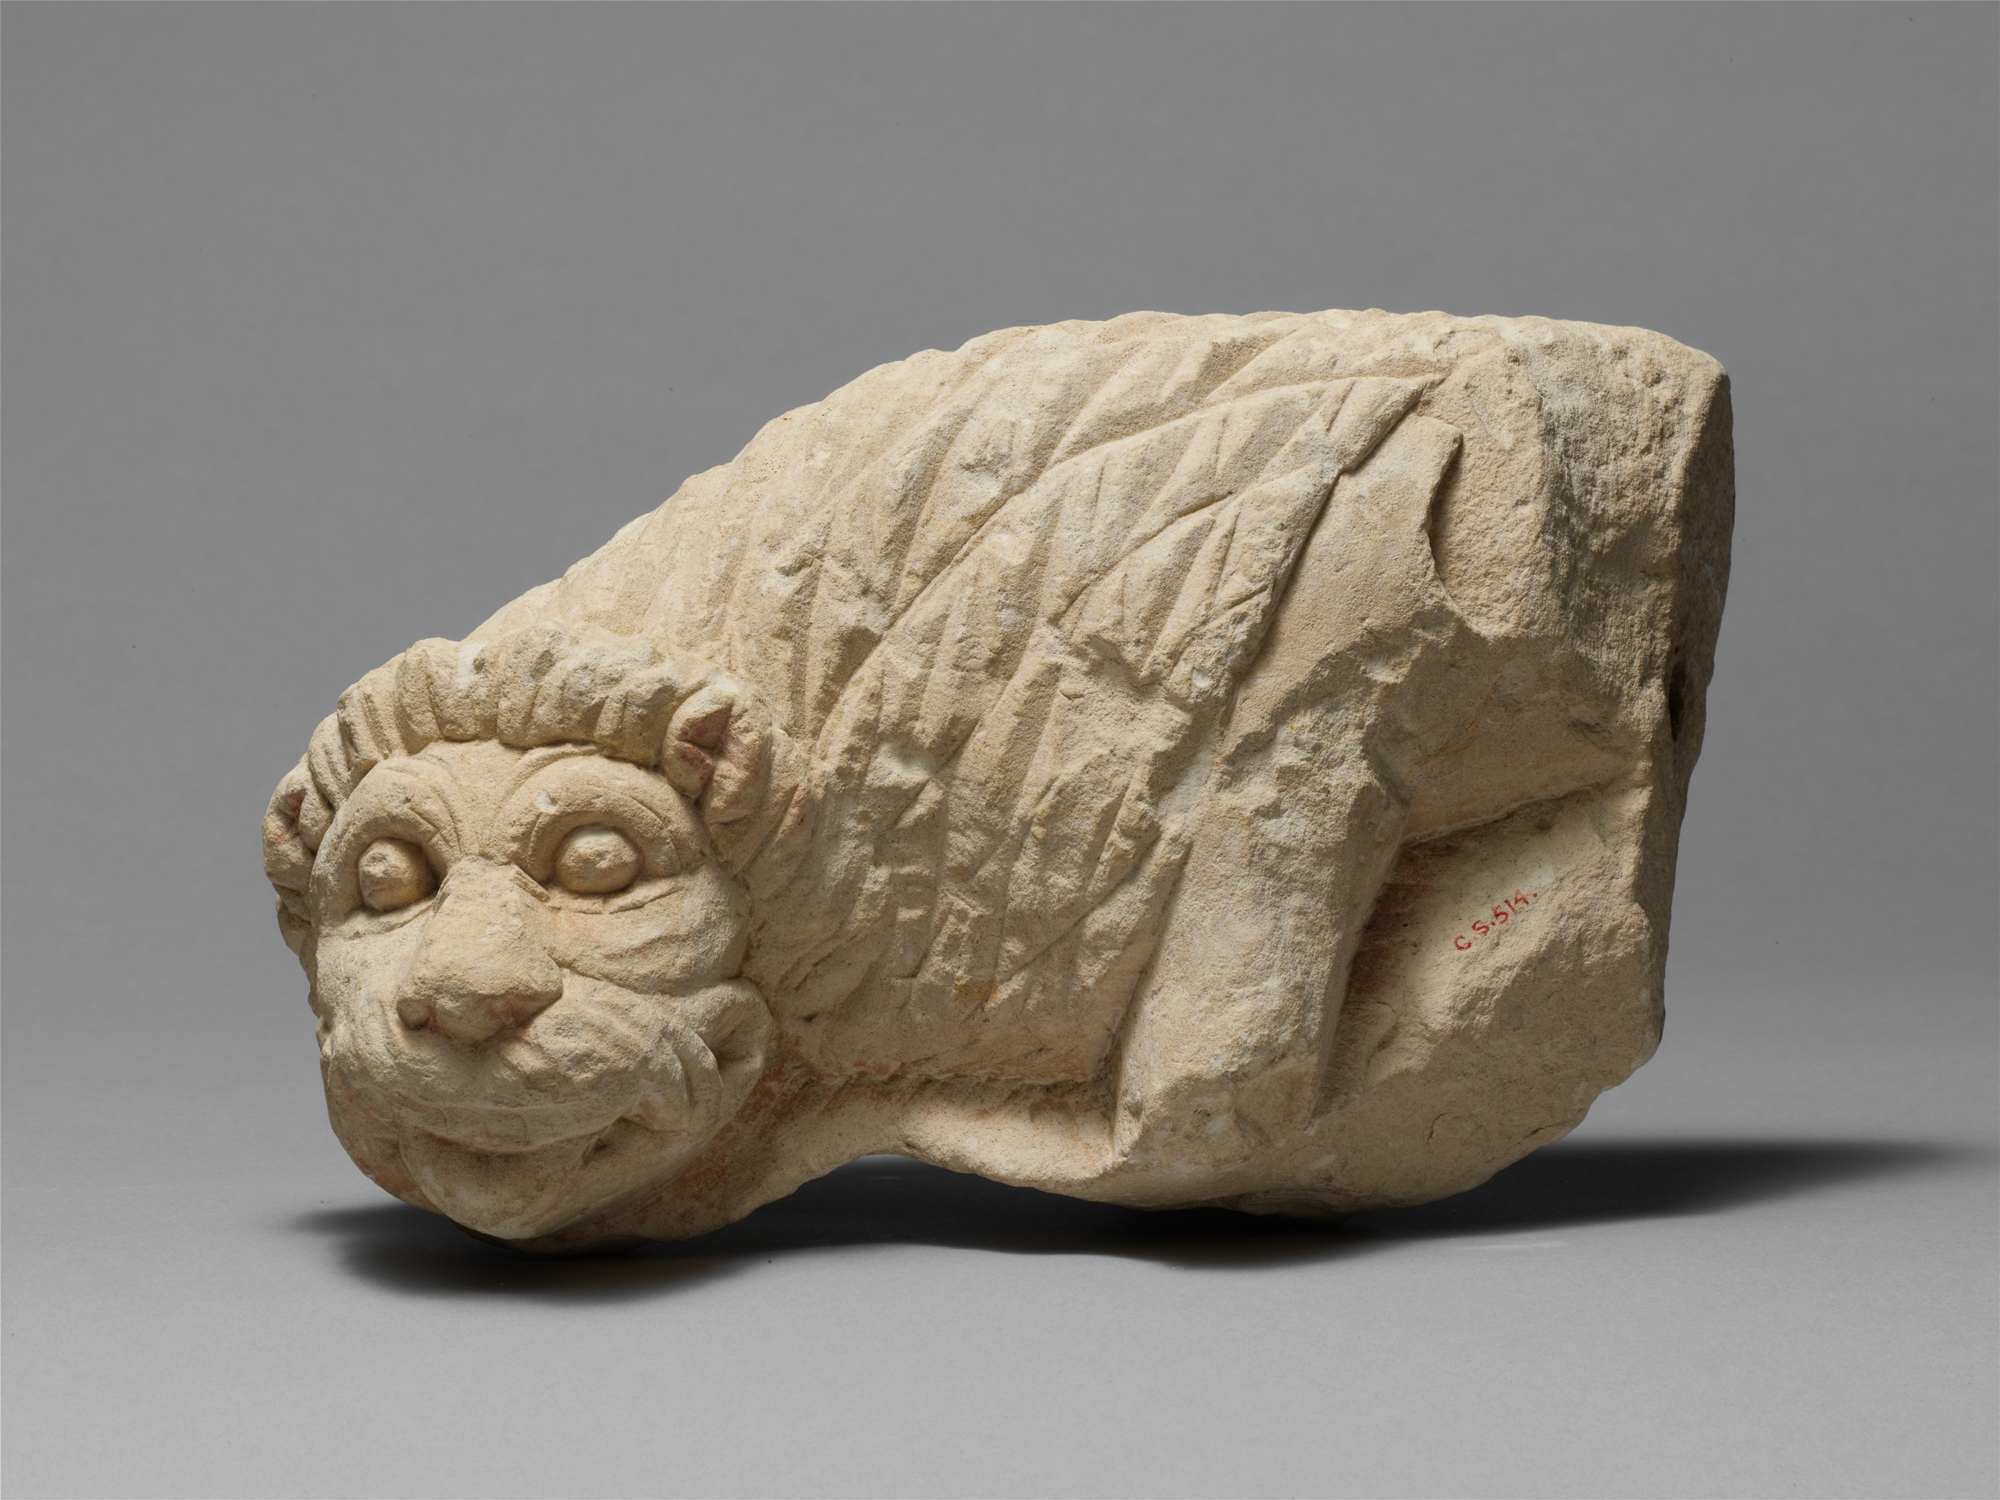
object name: statuette of a lion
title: Limestone statue of a lion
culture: cypriot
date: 300-201 BCE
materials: limestone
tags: lions